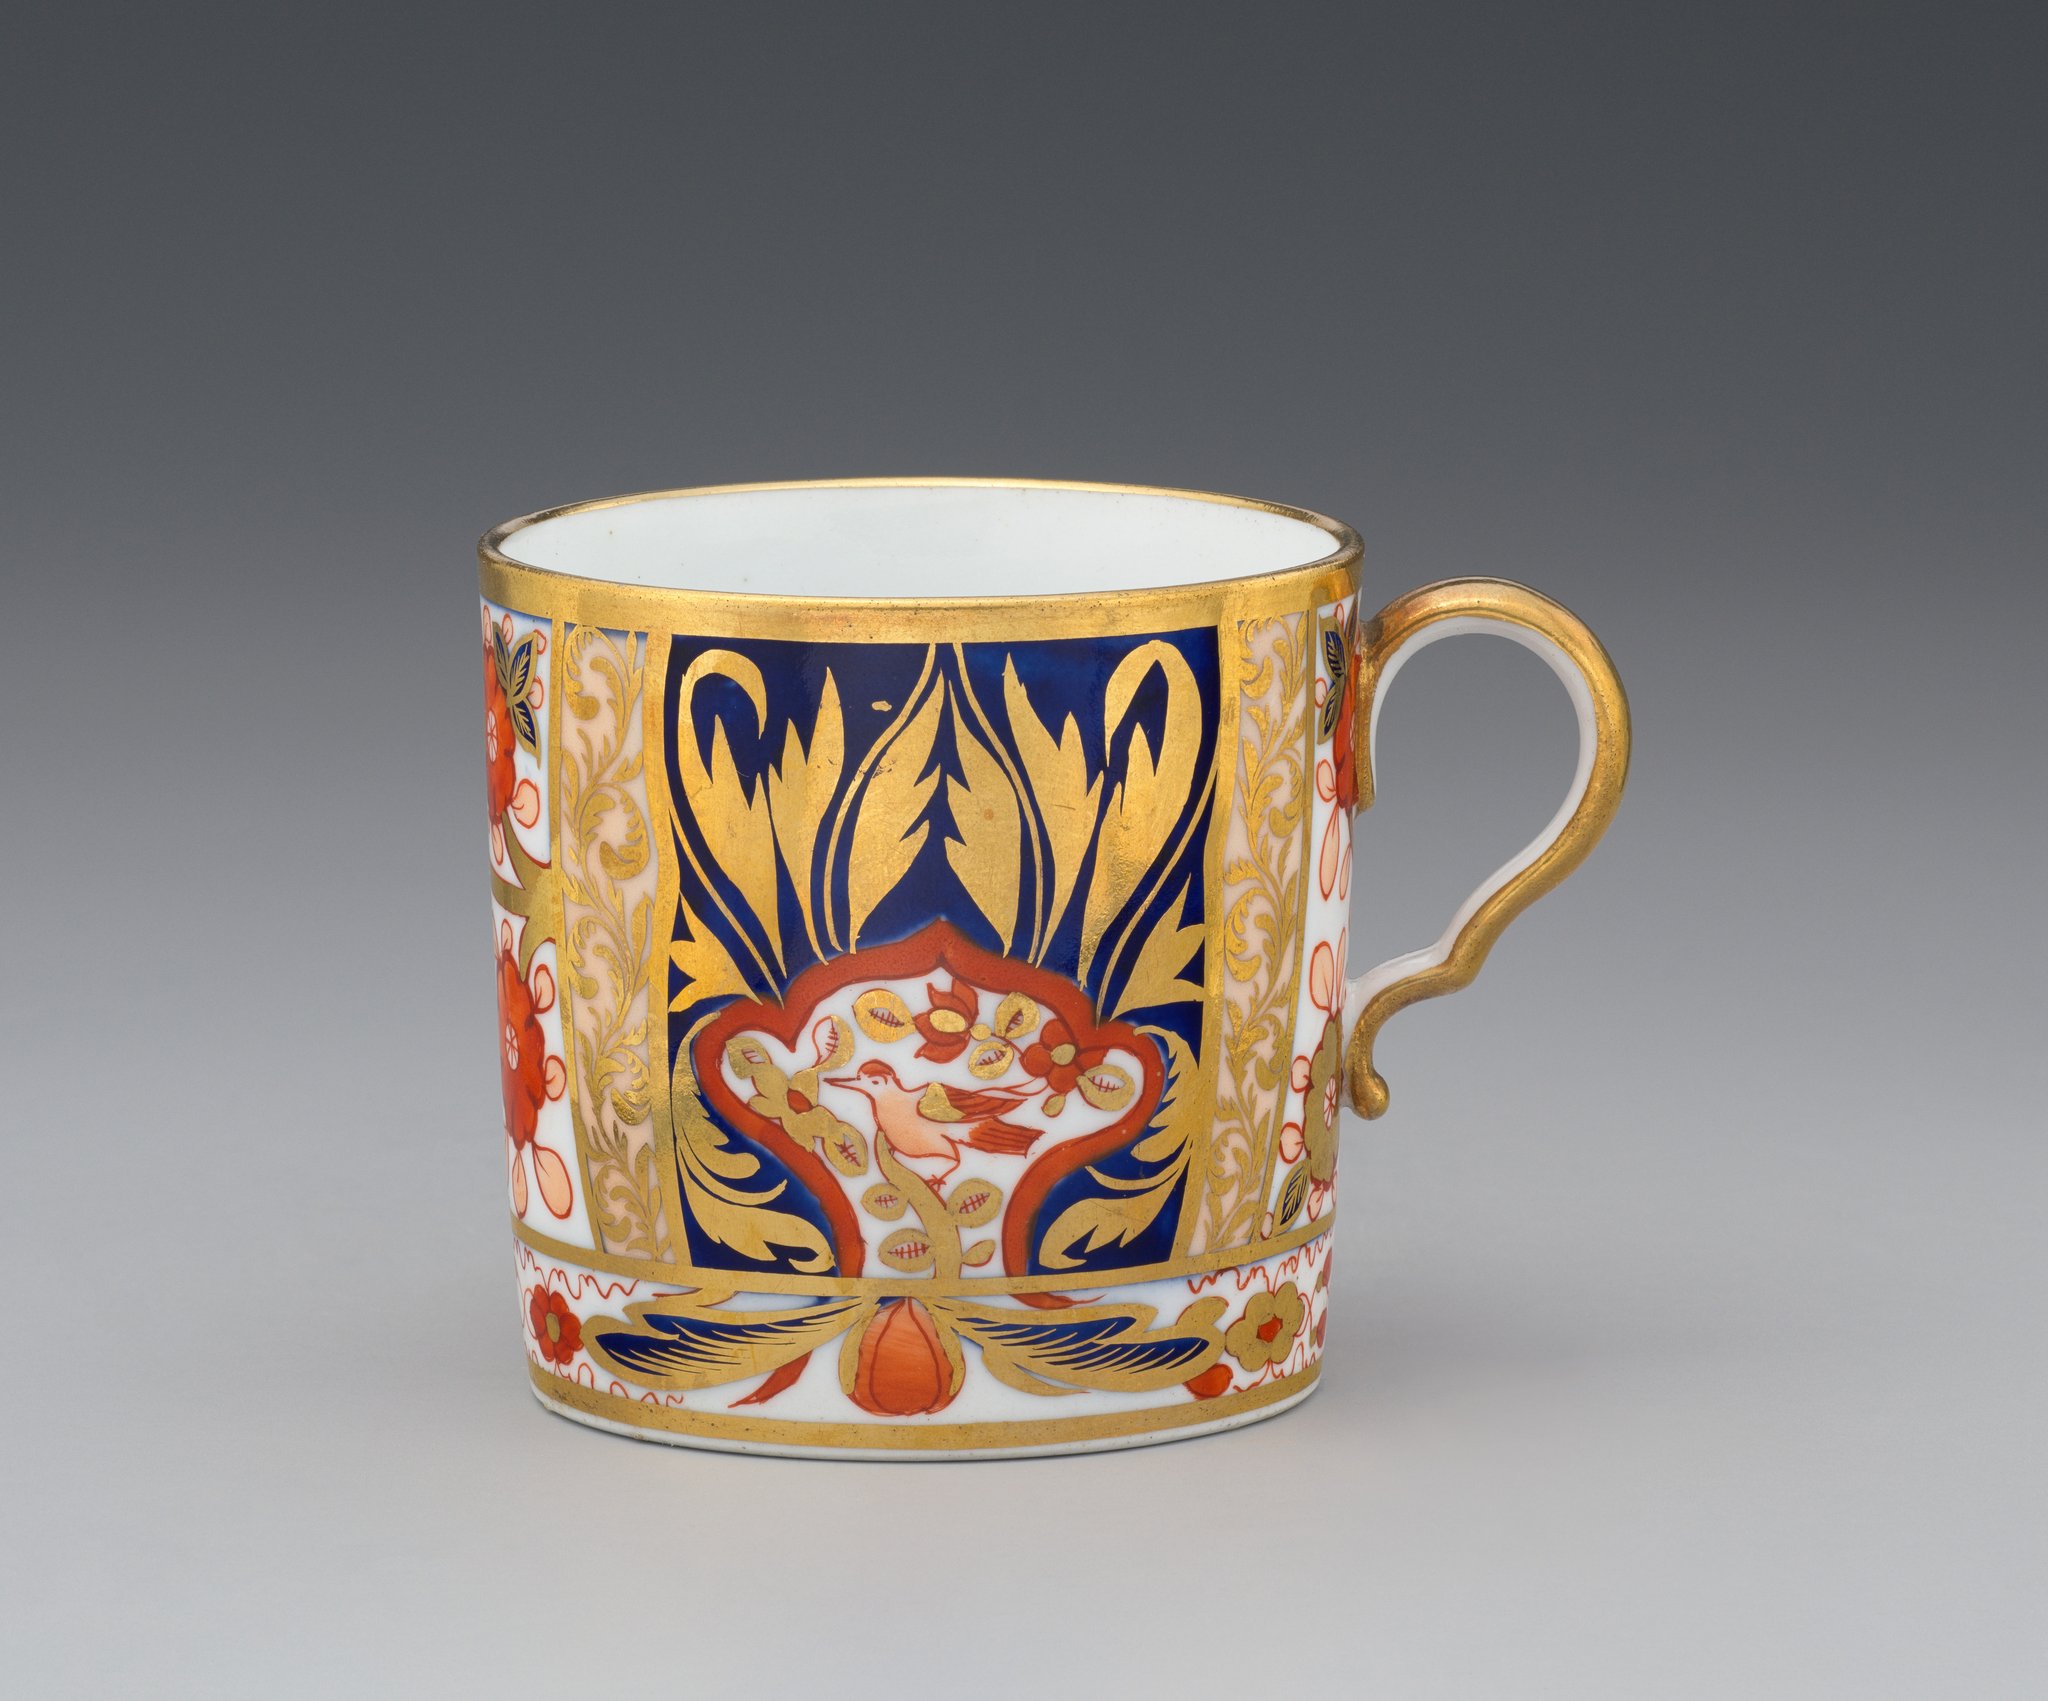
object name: cup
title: Cup (part of a service)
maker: j. spode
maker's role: factory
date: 1800-1830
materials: soft paste porcelain